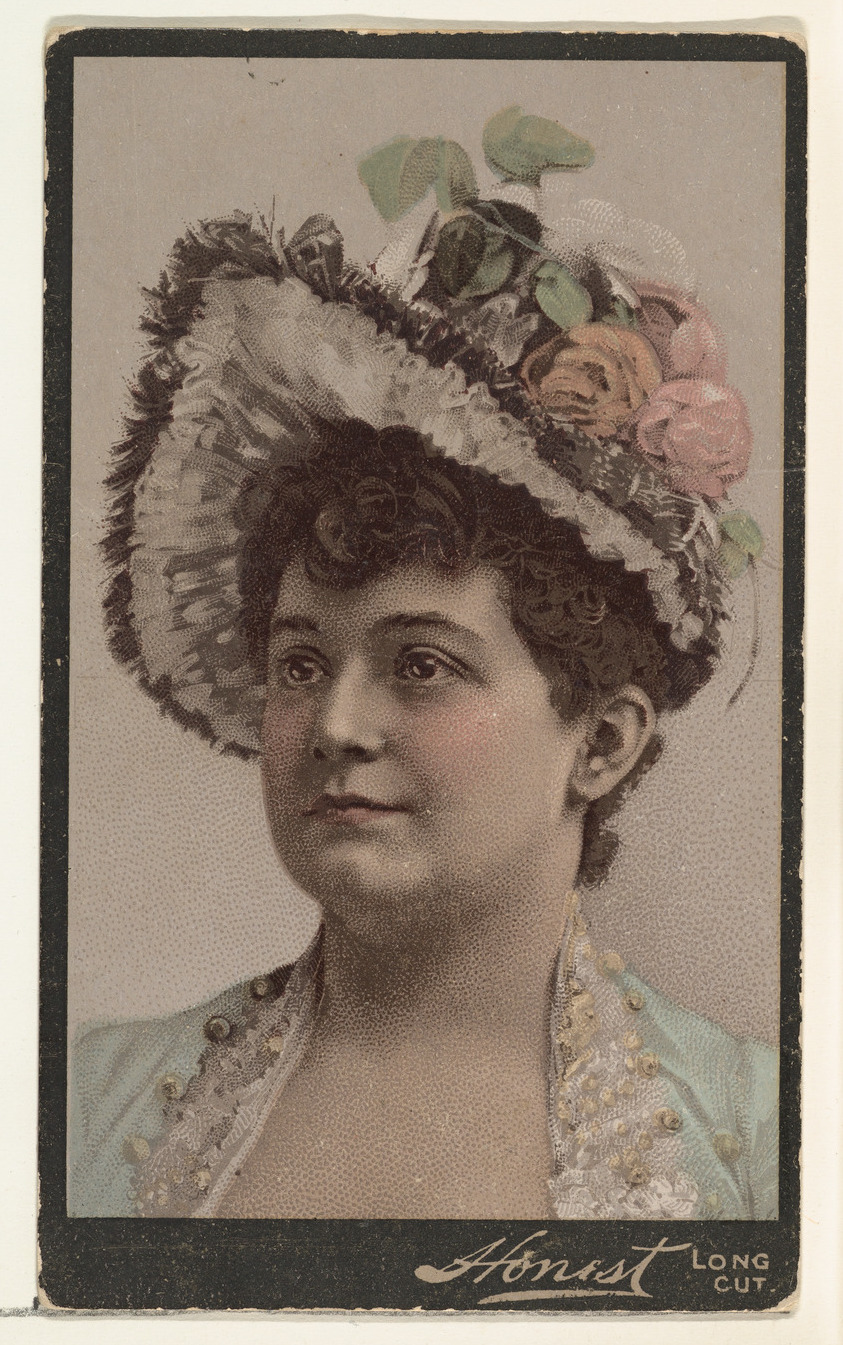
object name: print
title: Actress wearing elaborate hat with flowers, from Stars of the Stage, Third Series (N131) issued by Duke Sons & Co. to promote Honest Long Cut Tobacco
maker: w. duke, sons & co.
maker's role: publisher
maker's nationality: american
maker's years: 1870-1920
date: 1891-1892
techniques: color lithograph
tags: portraits,women,actresses